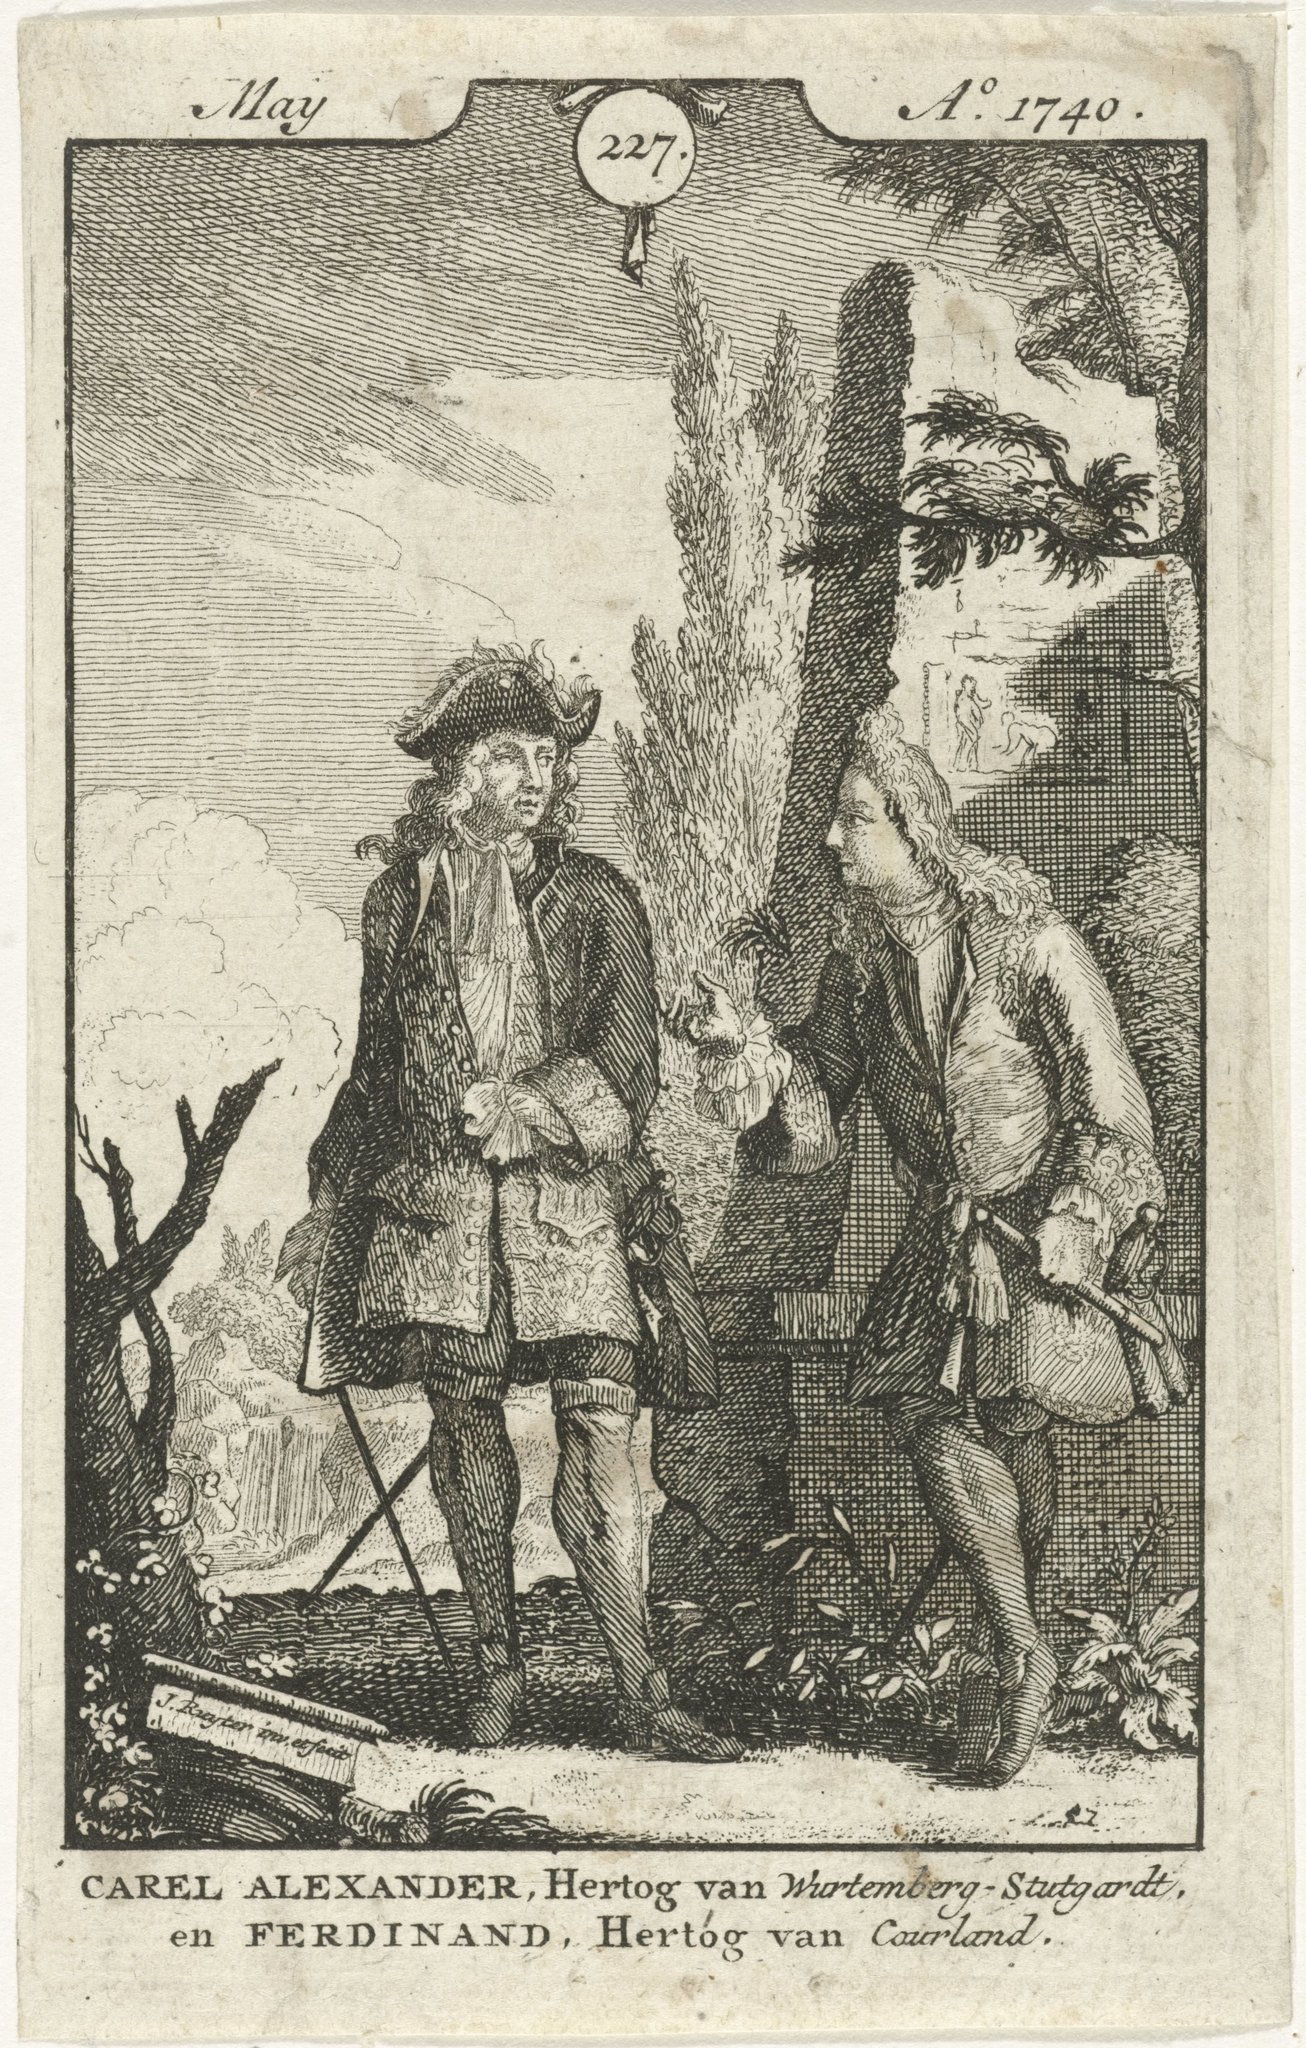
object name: print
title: Gesprek tussen Ferdinand Kettler en Karel Alexander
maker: johannes de ruijter (1688-1744)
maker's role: print maker, publisher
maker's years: 1688-1744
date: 1740-1744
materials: paper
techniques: etching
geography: amsterdam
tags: conversation, dialogue; conversation piece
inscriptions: inscription: ‘[...] Hoorn... 1 / Haarlem... 1 / Amsterdam... 1 / [...]’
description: In de buitenlucht bij een ruïneuze muur, zijn de reeds overleden Ferdinand Kettler, hertog van Koerland en Karel Alexander, hertog van Württemberg, met elkaar in gesprek.